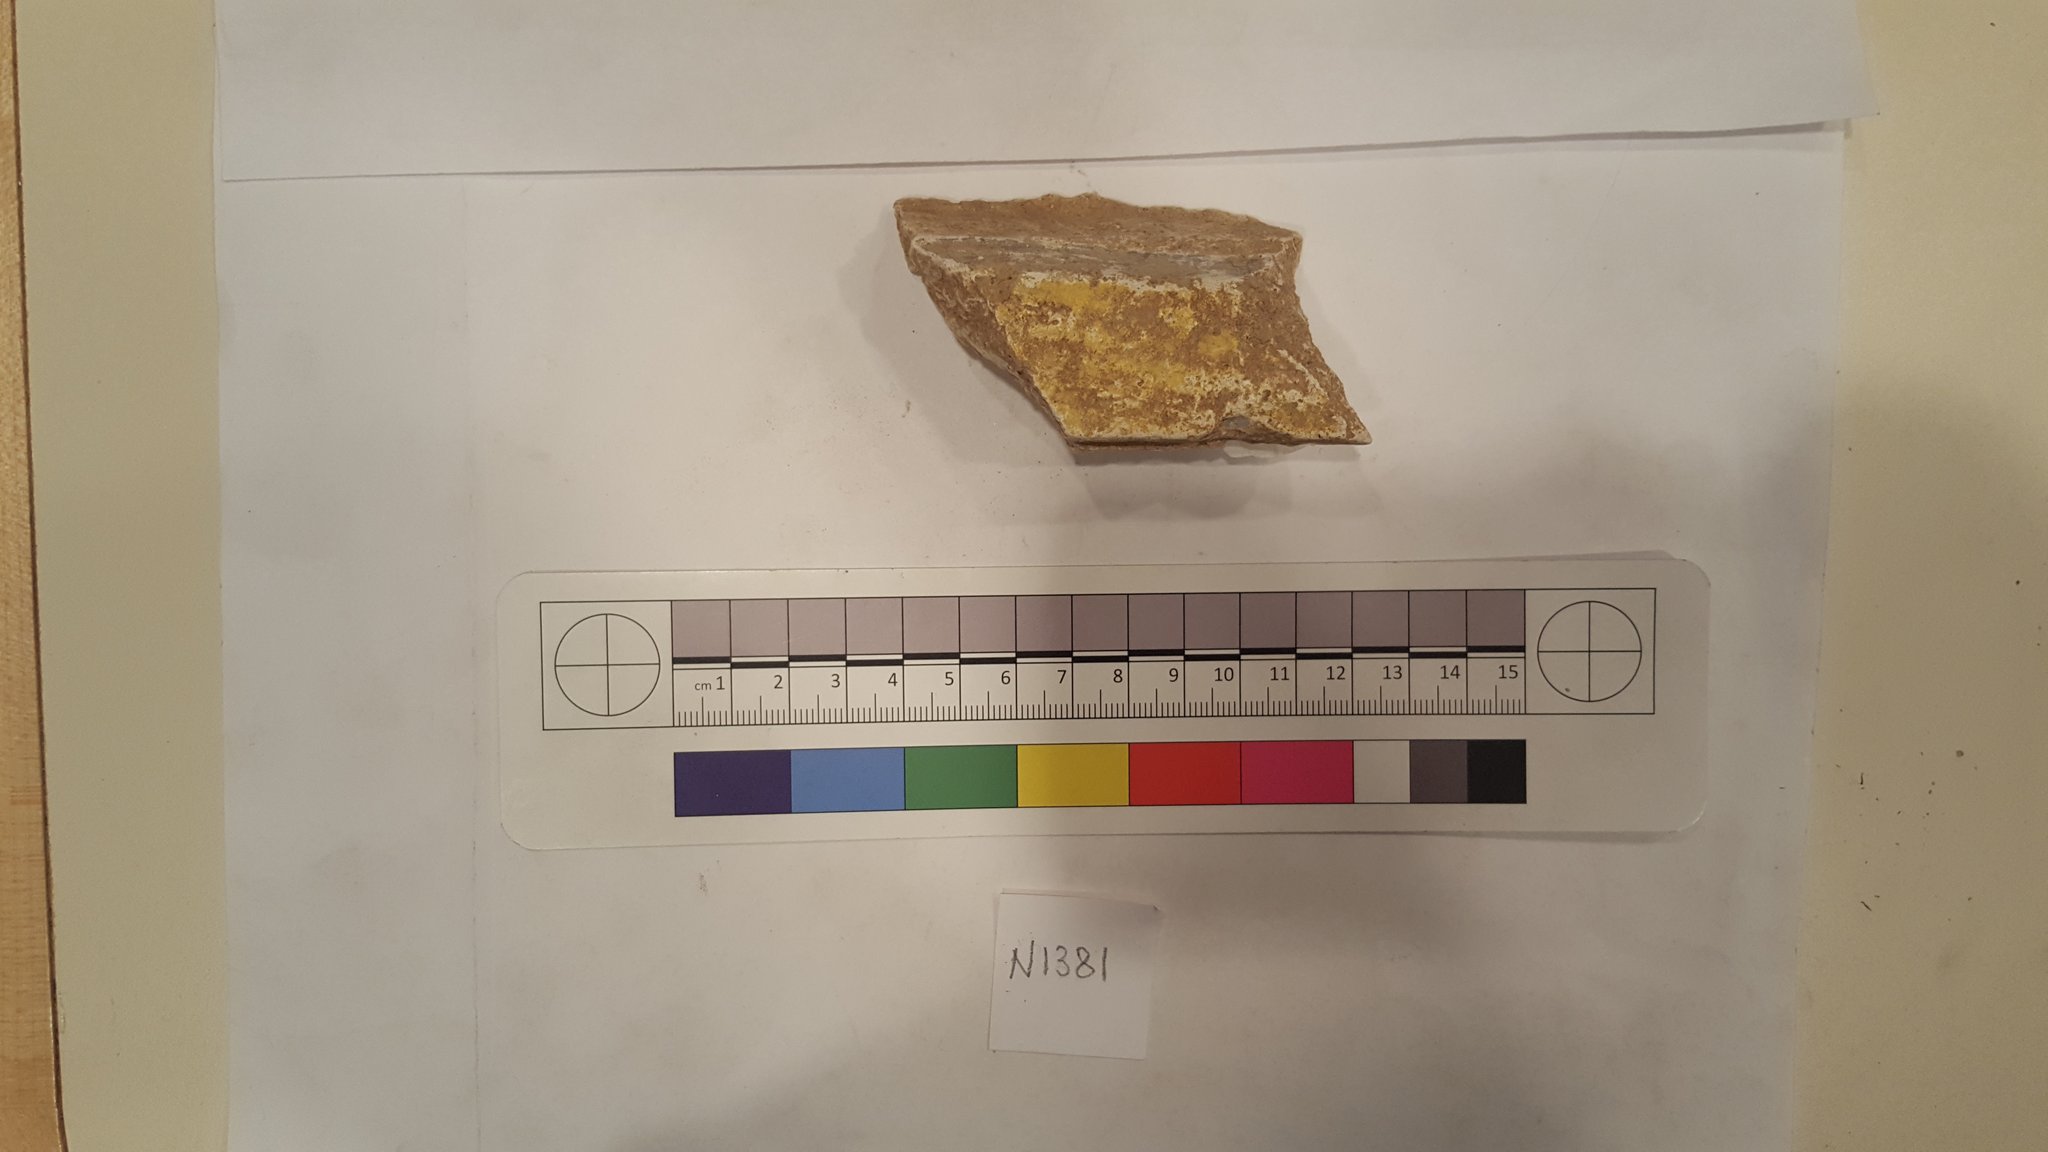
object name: fragment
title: Stucco Fragment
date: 701-1200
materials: plaster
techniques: carving, painting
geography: iran